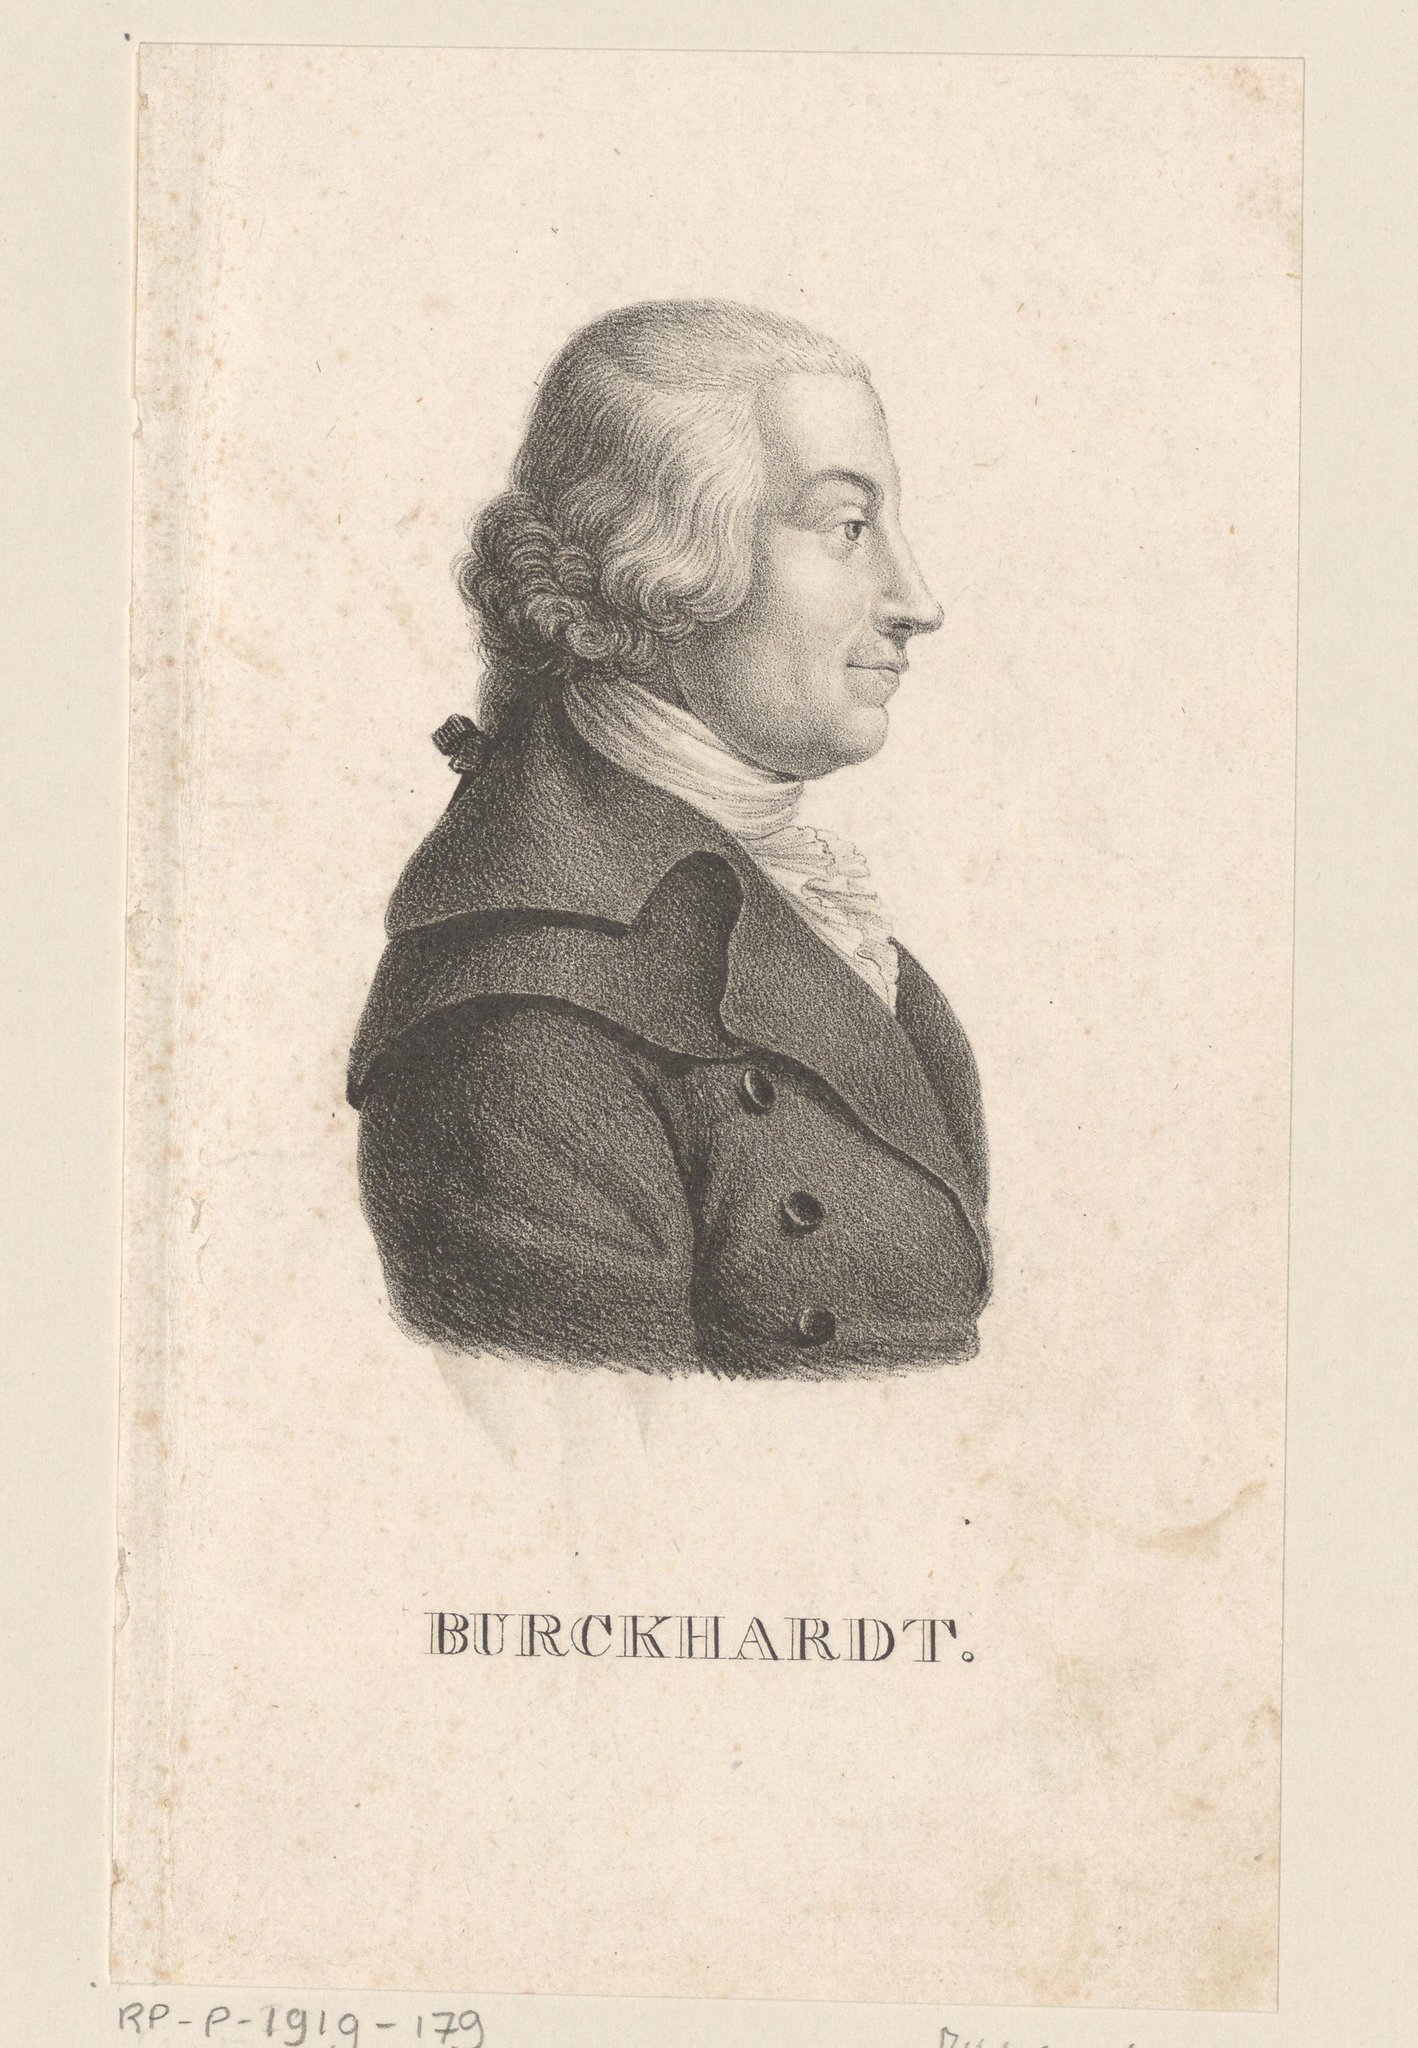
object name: print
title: Portret van Johann Carl Burckhardt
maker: Anonymous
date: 1800-1849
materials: paper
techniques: lithograph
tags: scholar, philosopher, historical persons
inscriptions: collector's mark: Lugt 2228